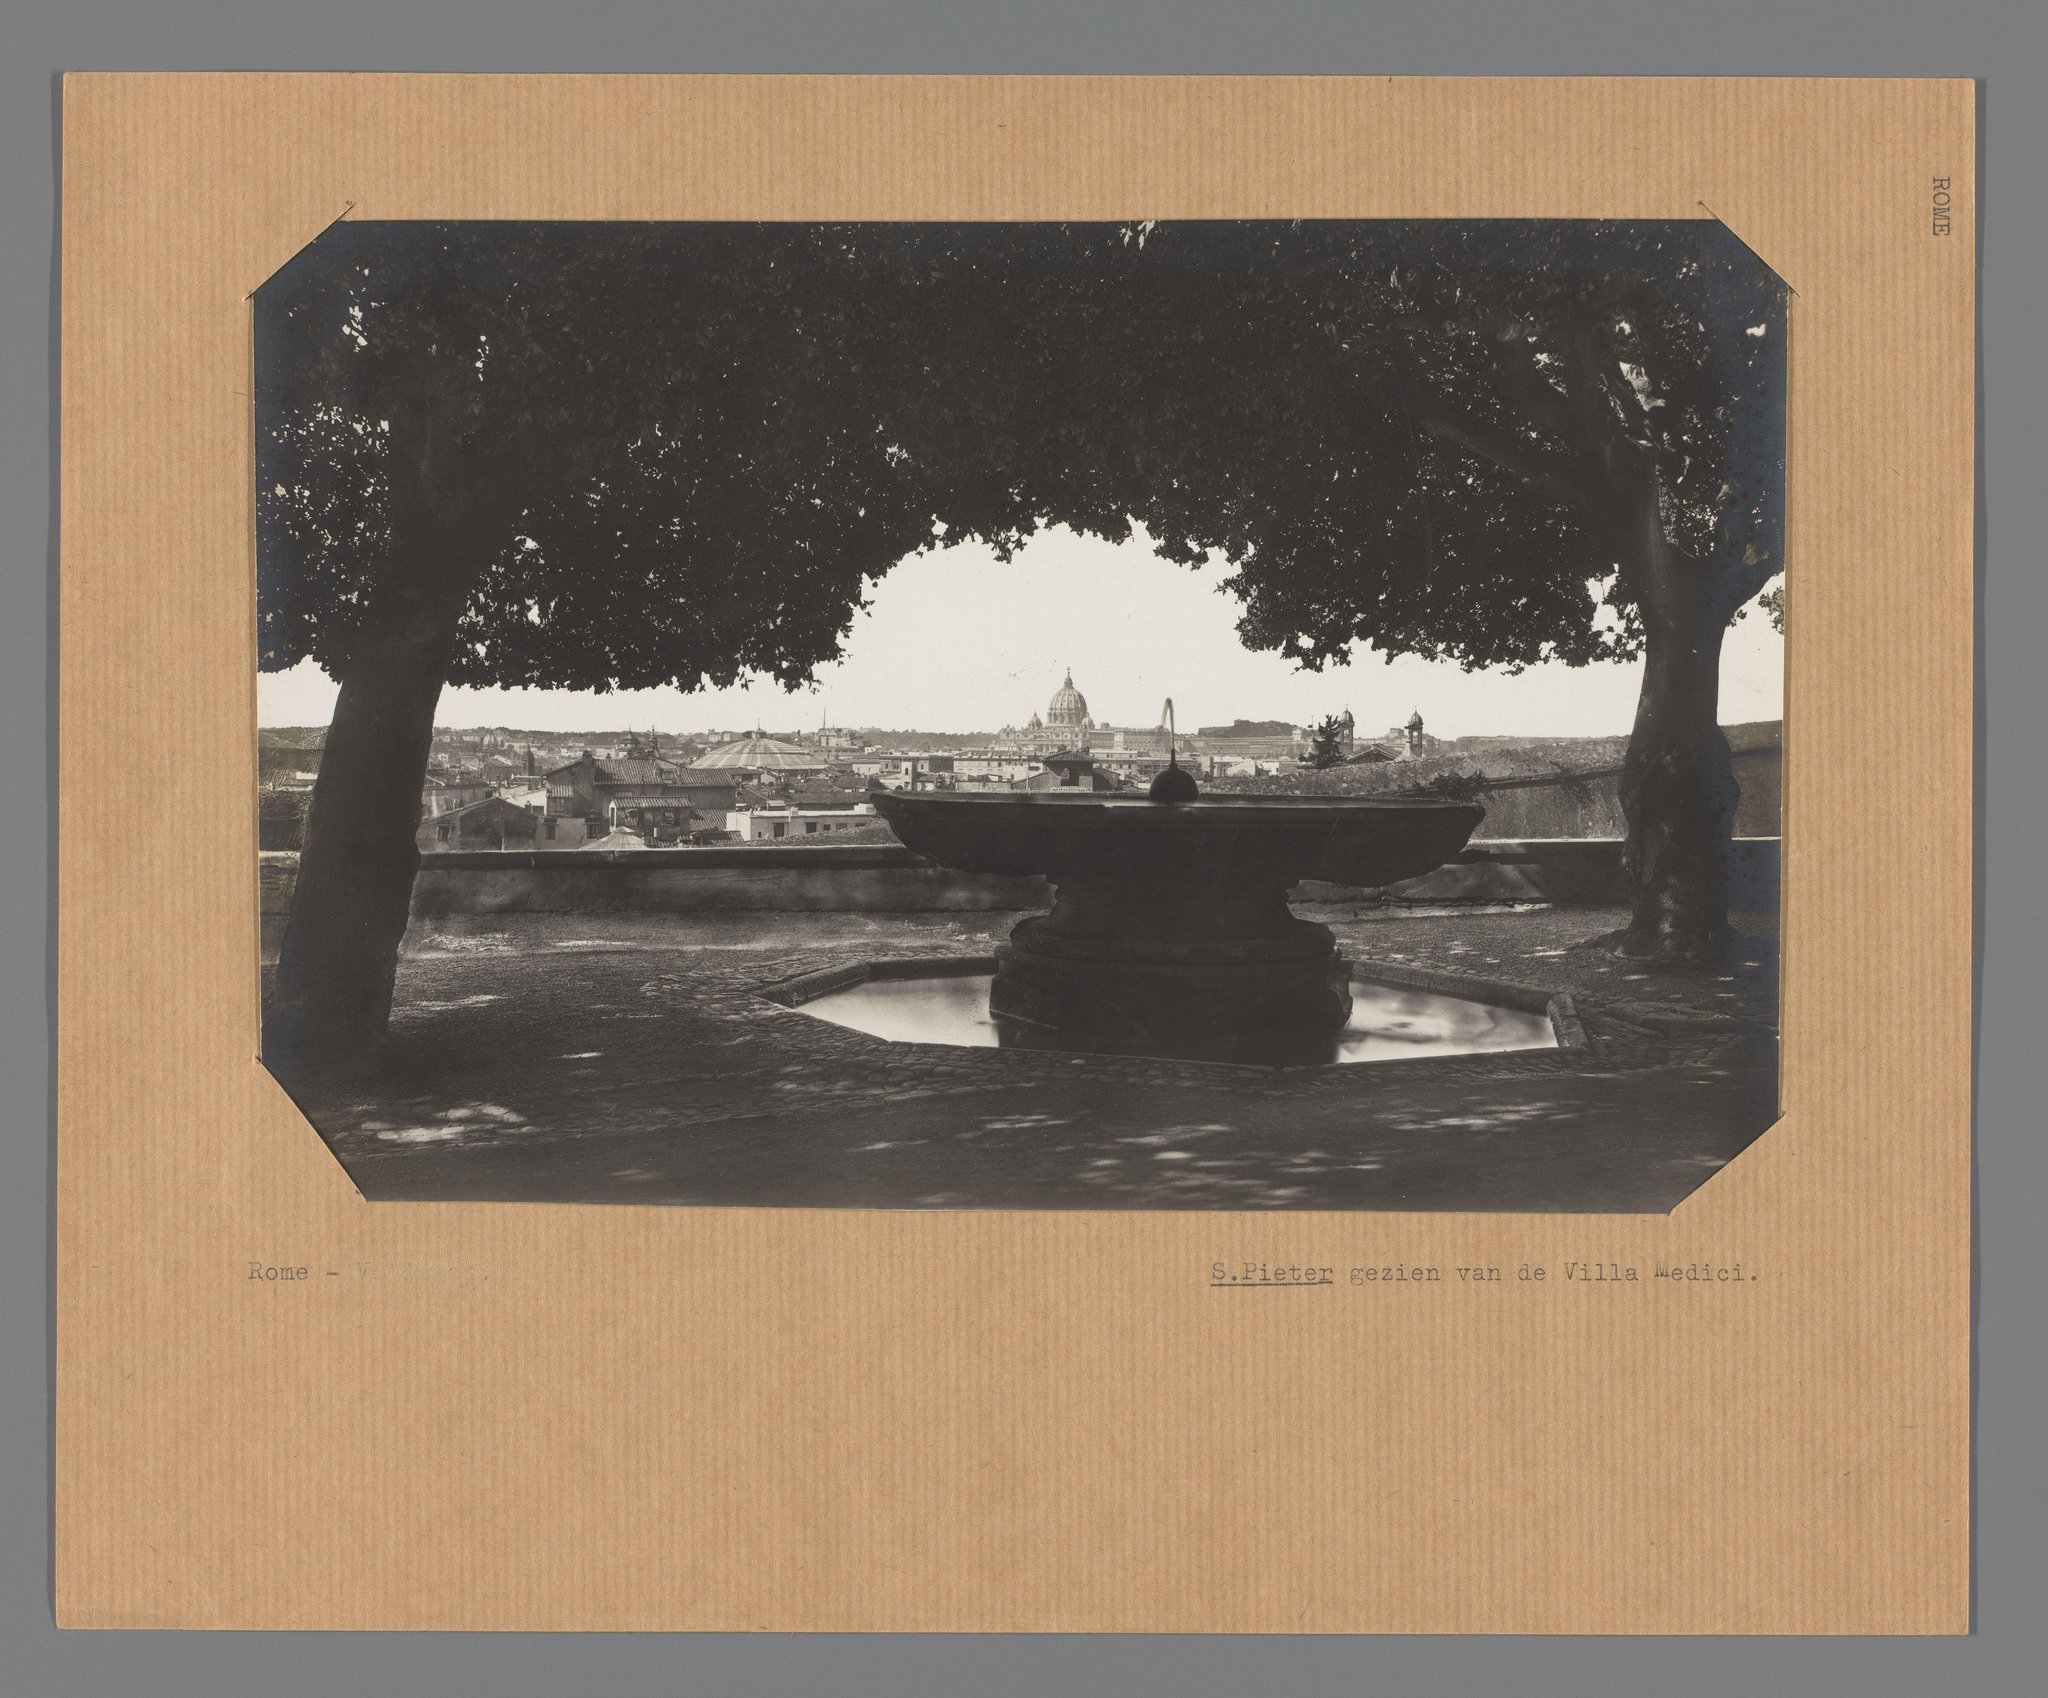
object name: photograph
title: Italië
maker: Anonymous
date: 1880-1910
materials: photographic support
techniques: albumen print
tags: italy